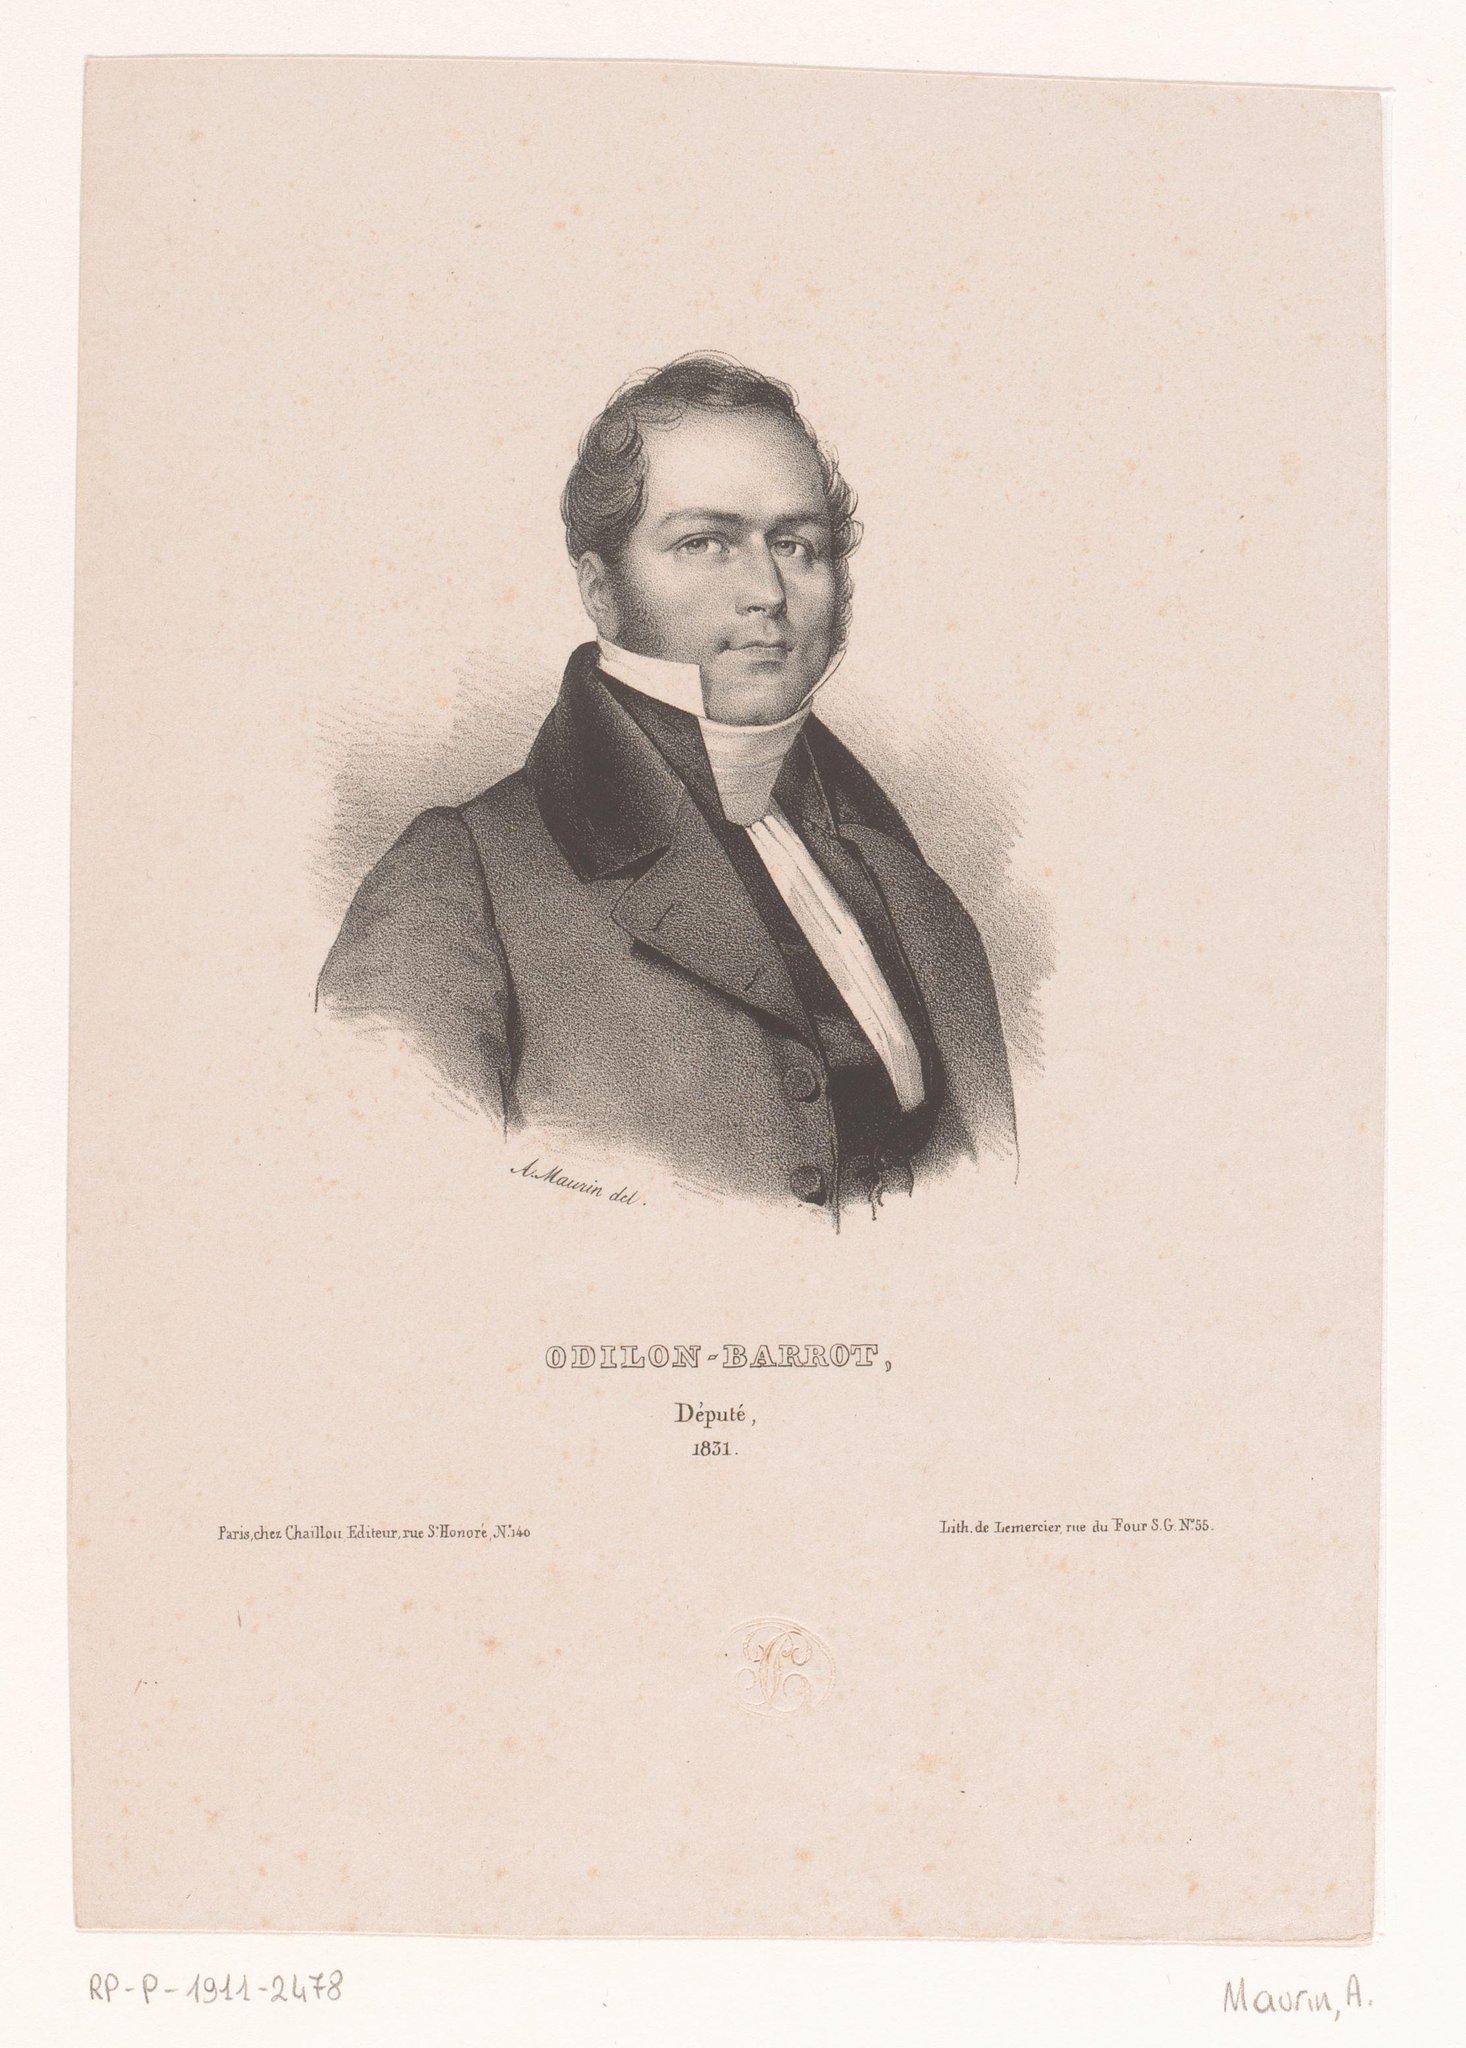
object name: print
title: Portret van Odilon-Barrot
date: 1831-1838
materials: paper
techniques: lithograph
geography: paris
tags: historical persons, politician, e.g. party leader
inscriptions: check stamp: Lugt 619, collector's mark: Lugt 2228